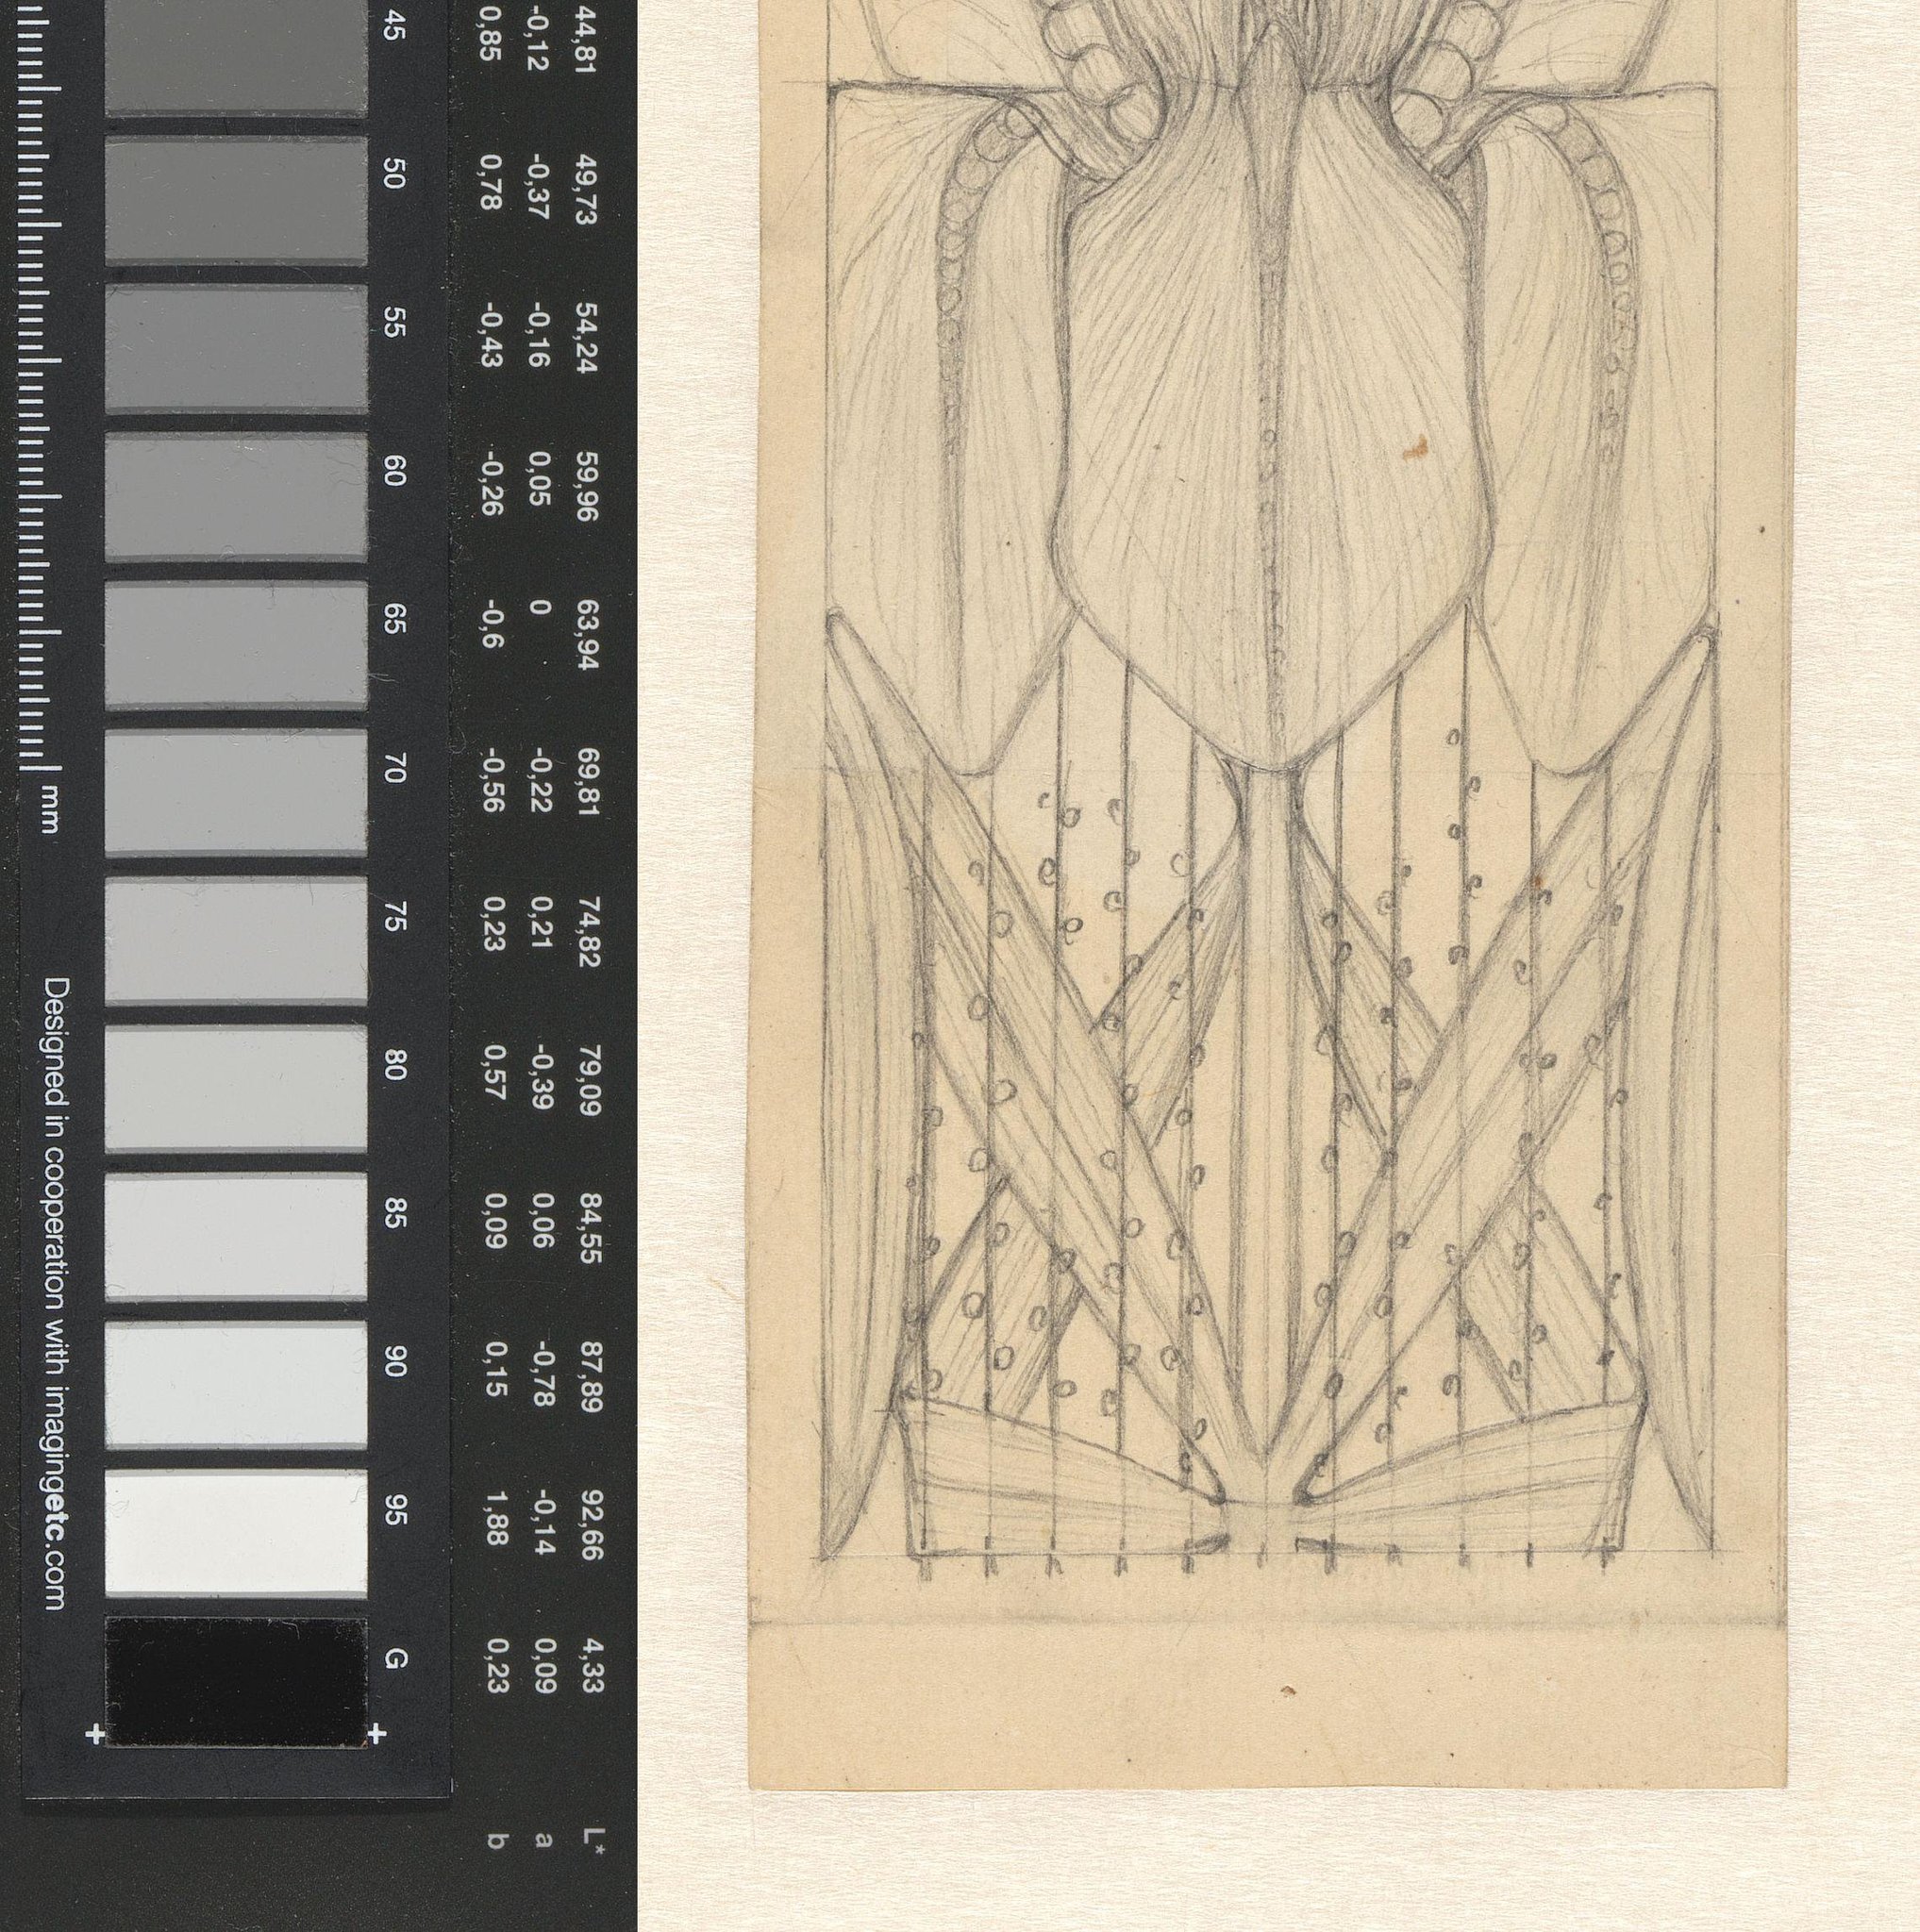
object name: drawing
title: Iris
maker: mathieu lauweriks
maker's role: designer, draughtsman, print maker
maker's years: 1864-1932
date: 1894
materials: paper, pencil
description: Gestileerde iris met op het grootste bloemblad een gezicht verwerkt in het bloempatroon.